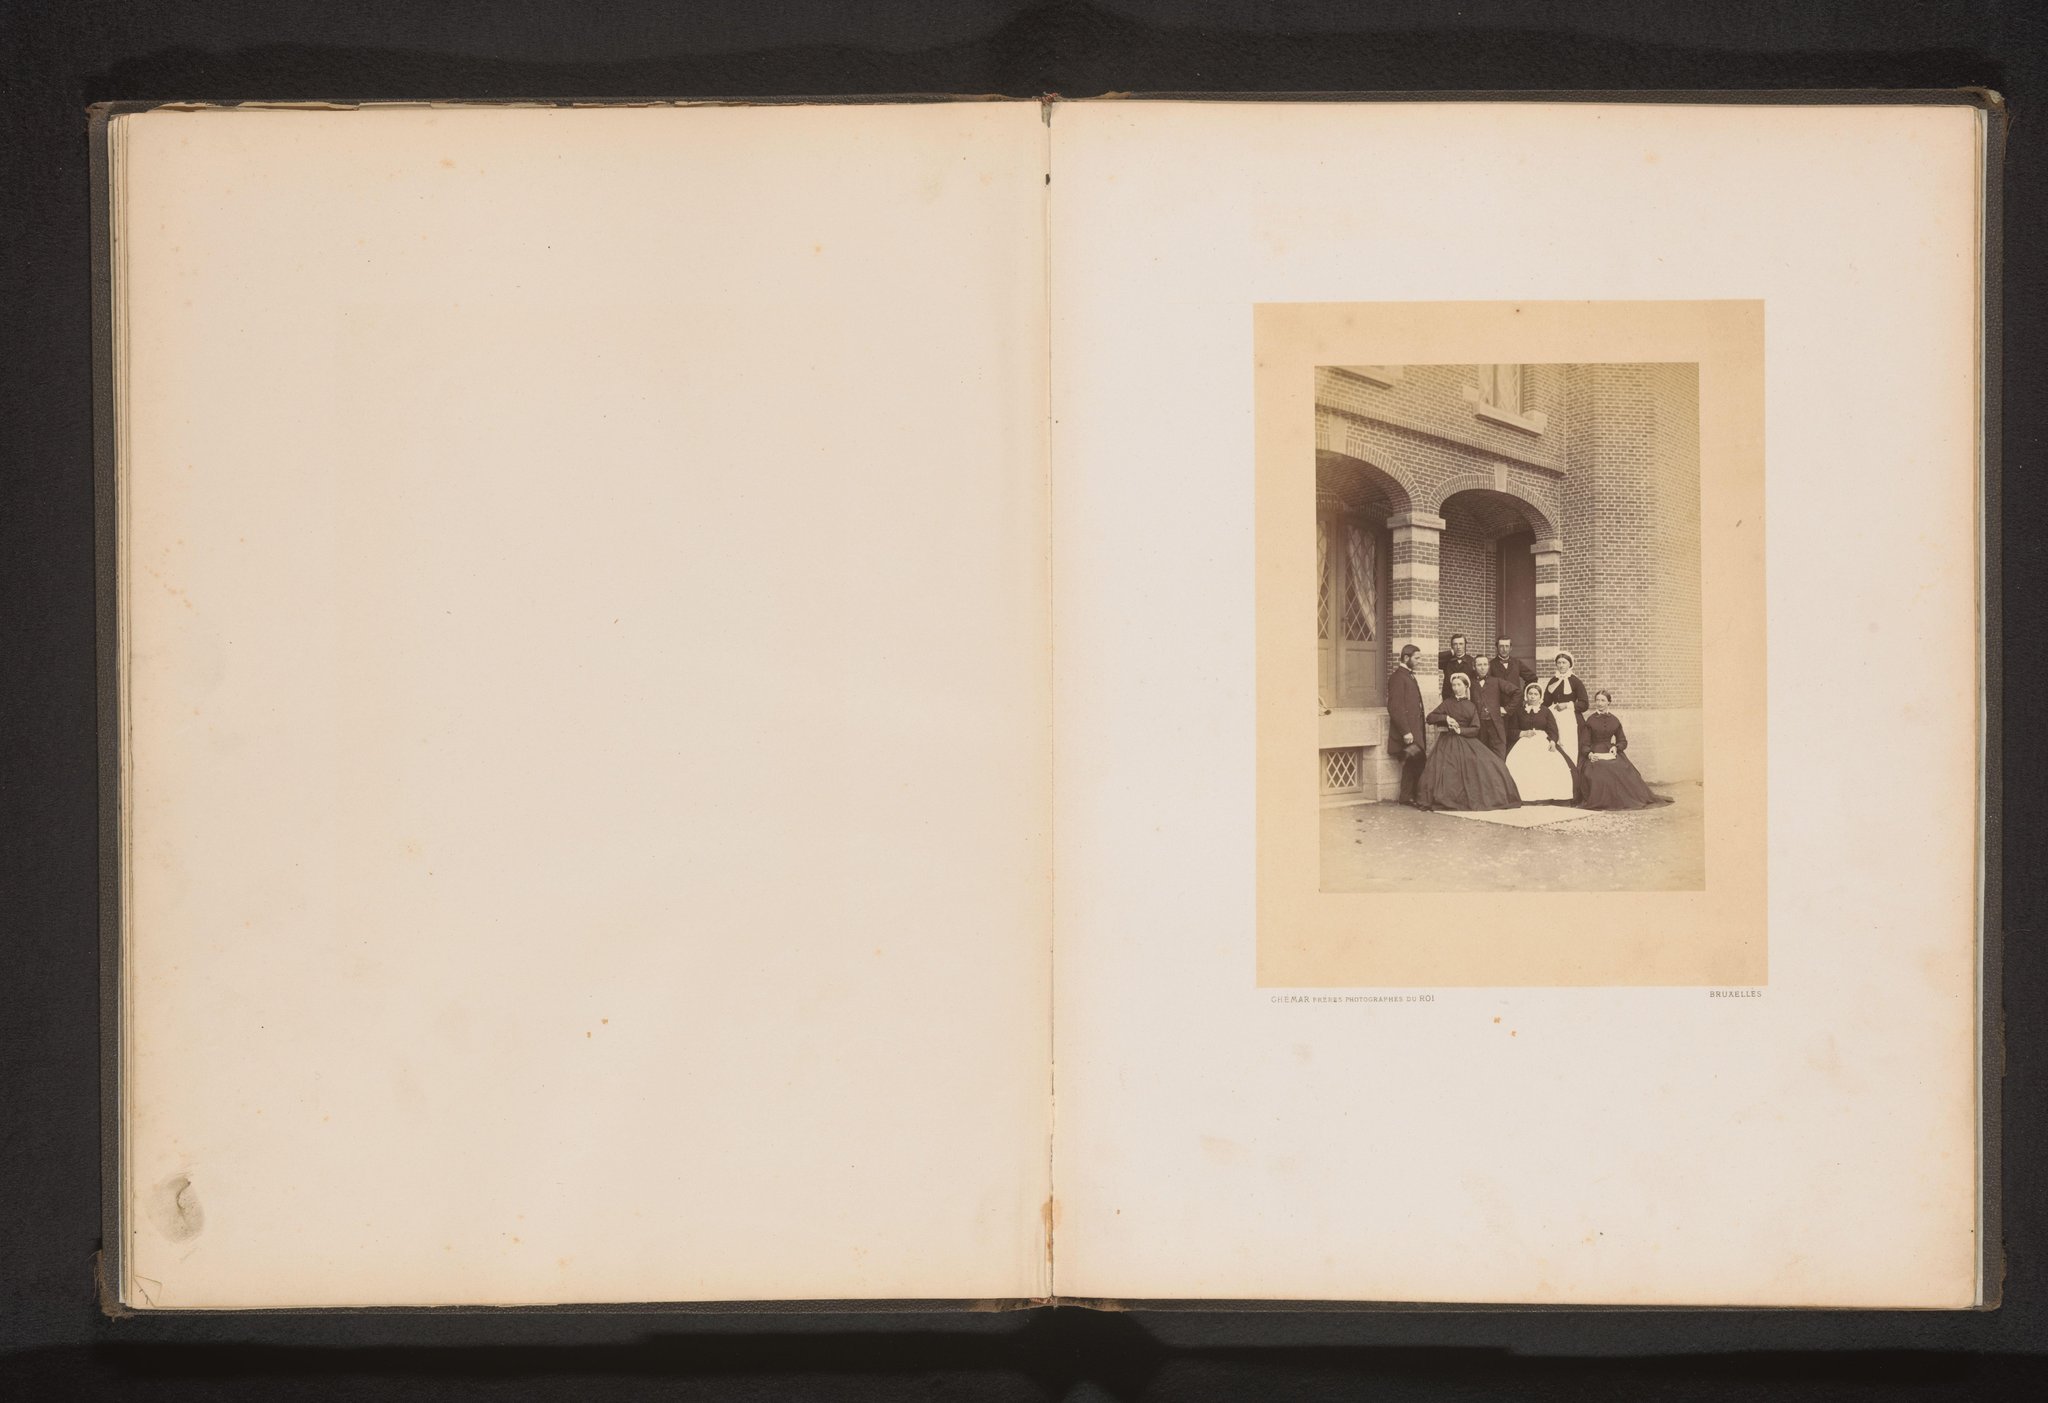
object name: page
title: Groepsportret van een onbekend gezelschap nabij Château de Marlagne te Wépion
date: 1862-1867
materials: photographic support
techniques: albumen print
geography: wépion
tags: castle, anonymous historical persons portrayed in a group, in a group-portrait